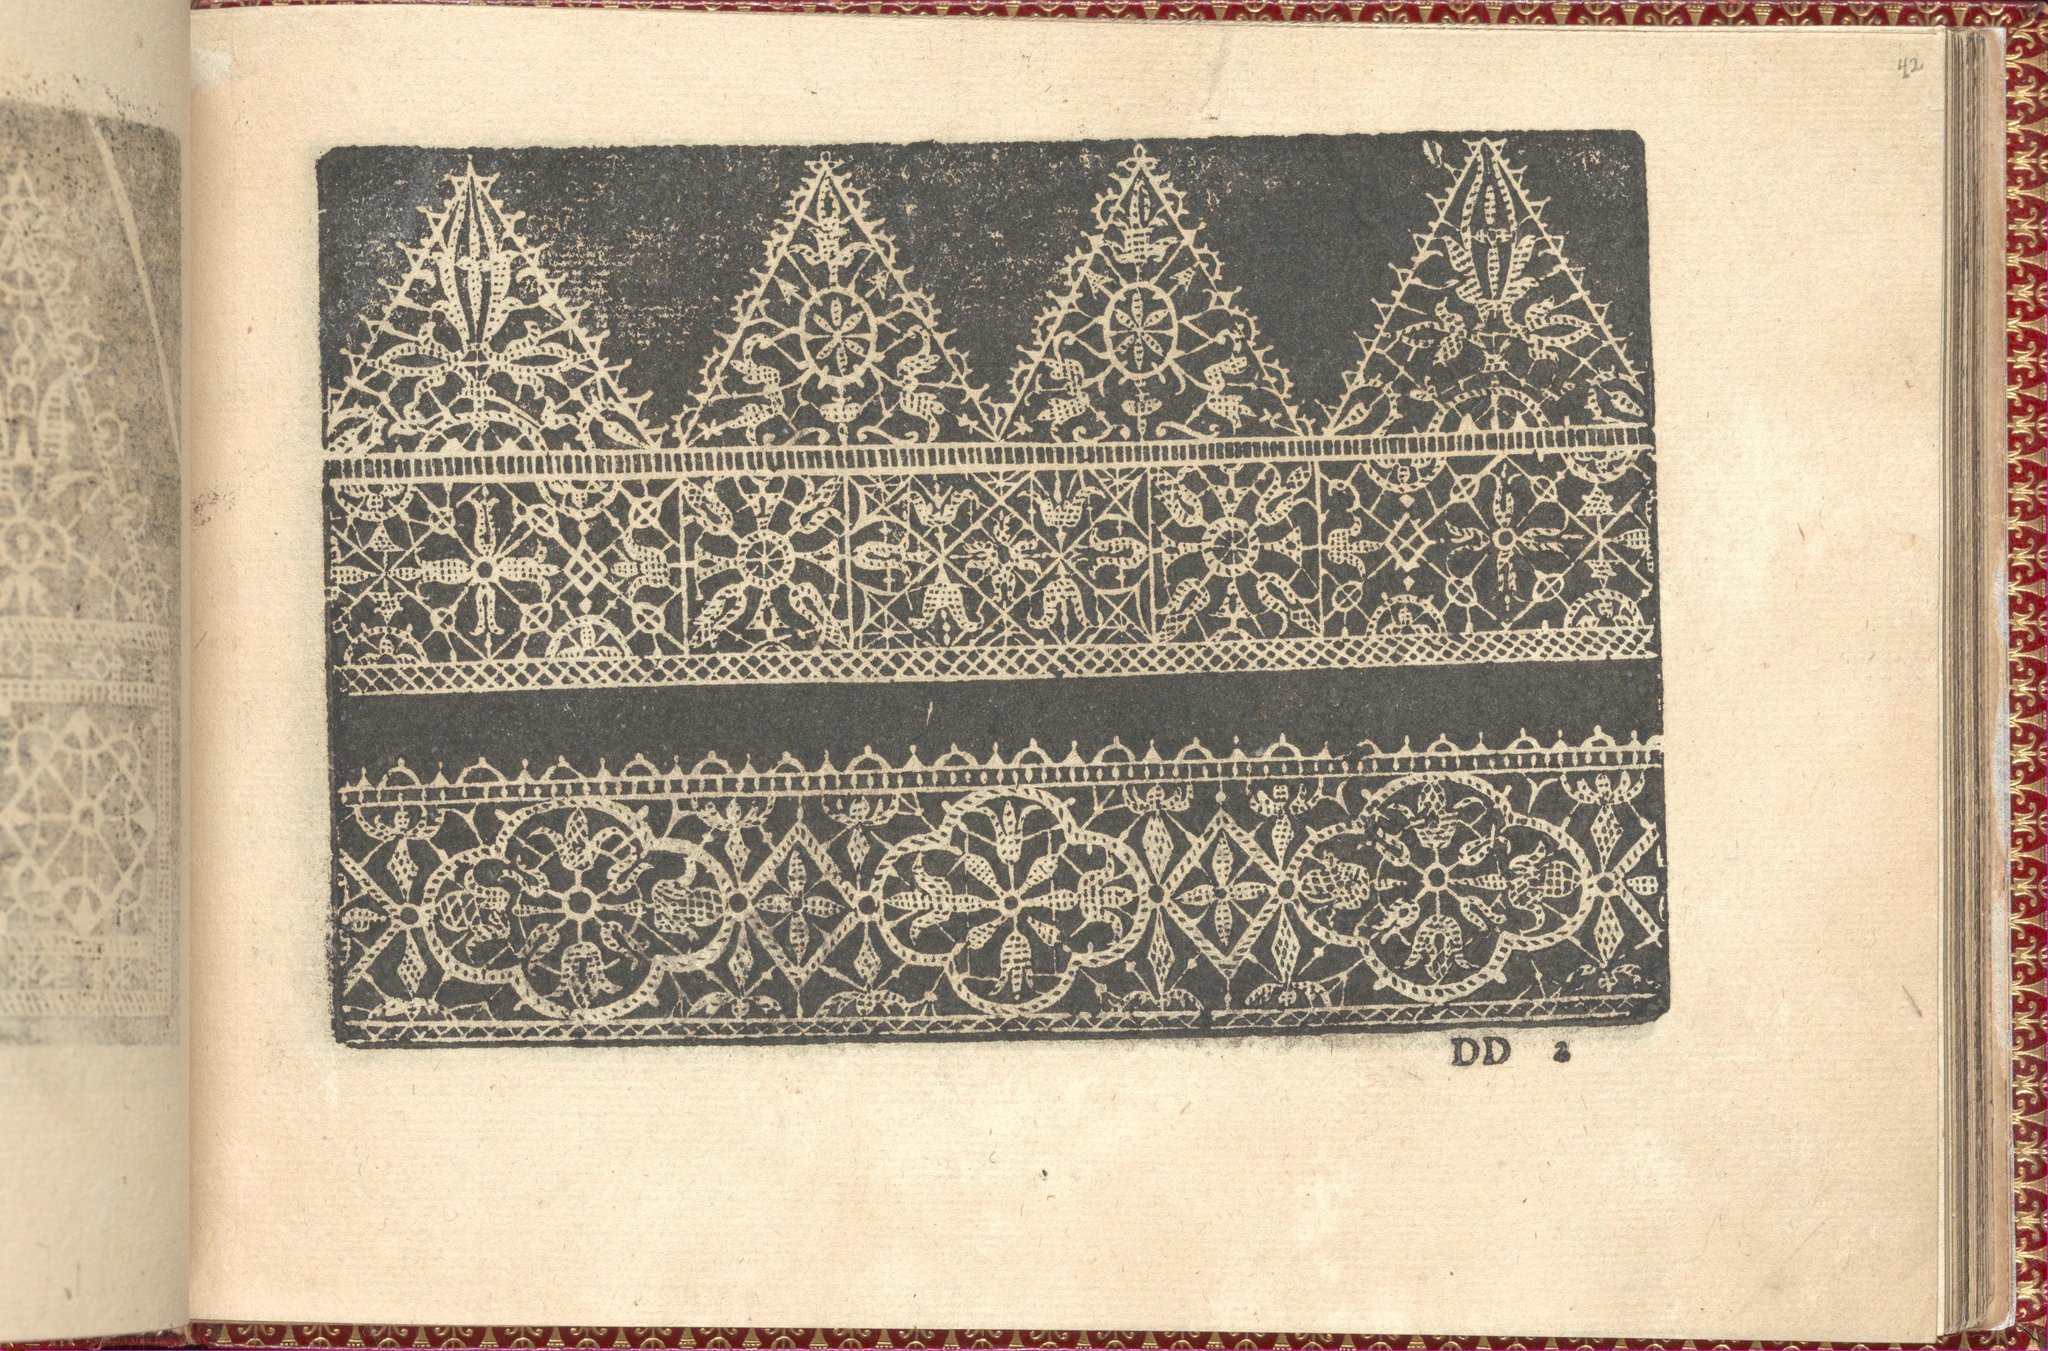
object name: book print ornament architecture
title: Corona delle Nobili et Virtuose Donne: Libro I-IV, page 42 (recto)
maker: cesare vecellio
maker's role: publisher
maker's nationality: italian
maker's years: 1521-1601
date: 1601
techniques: woodcut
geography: italy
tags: ornament